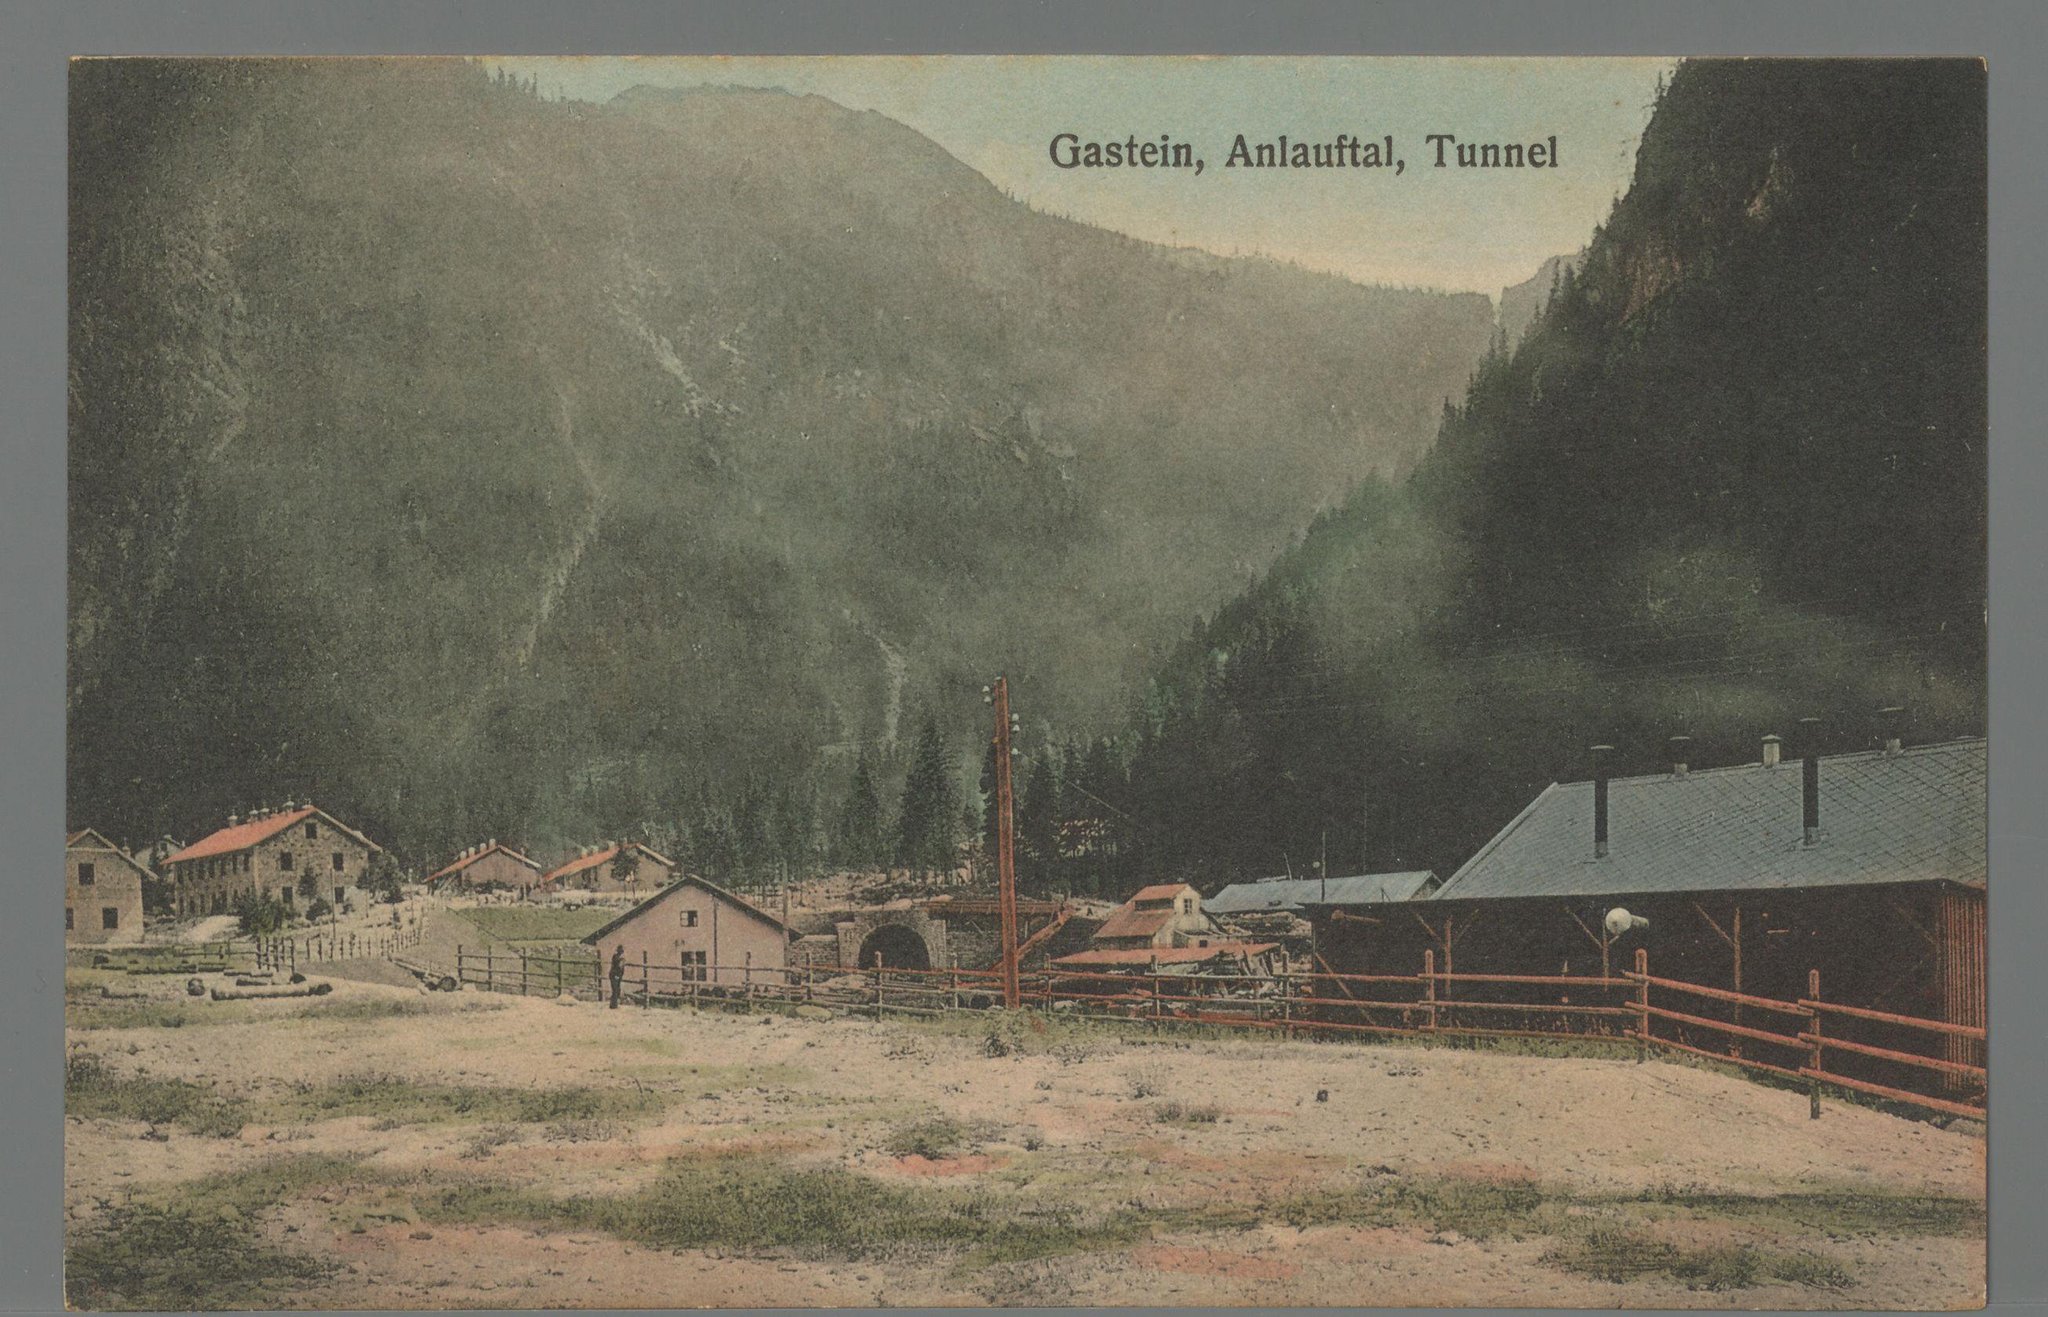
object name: ansichtkaart, prentbriefkaart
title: Gastein, Anlauftal, Tunnel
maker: Anonymous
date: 1904-1907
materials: cardboard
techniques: photograph, lithograph, writing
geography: vienna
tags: dale, valley, underground road, tunnel